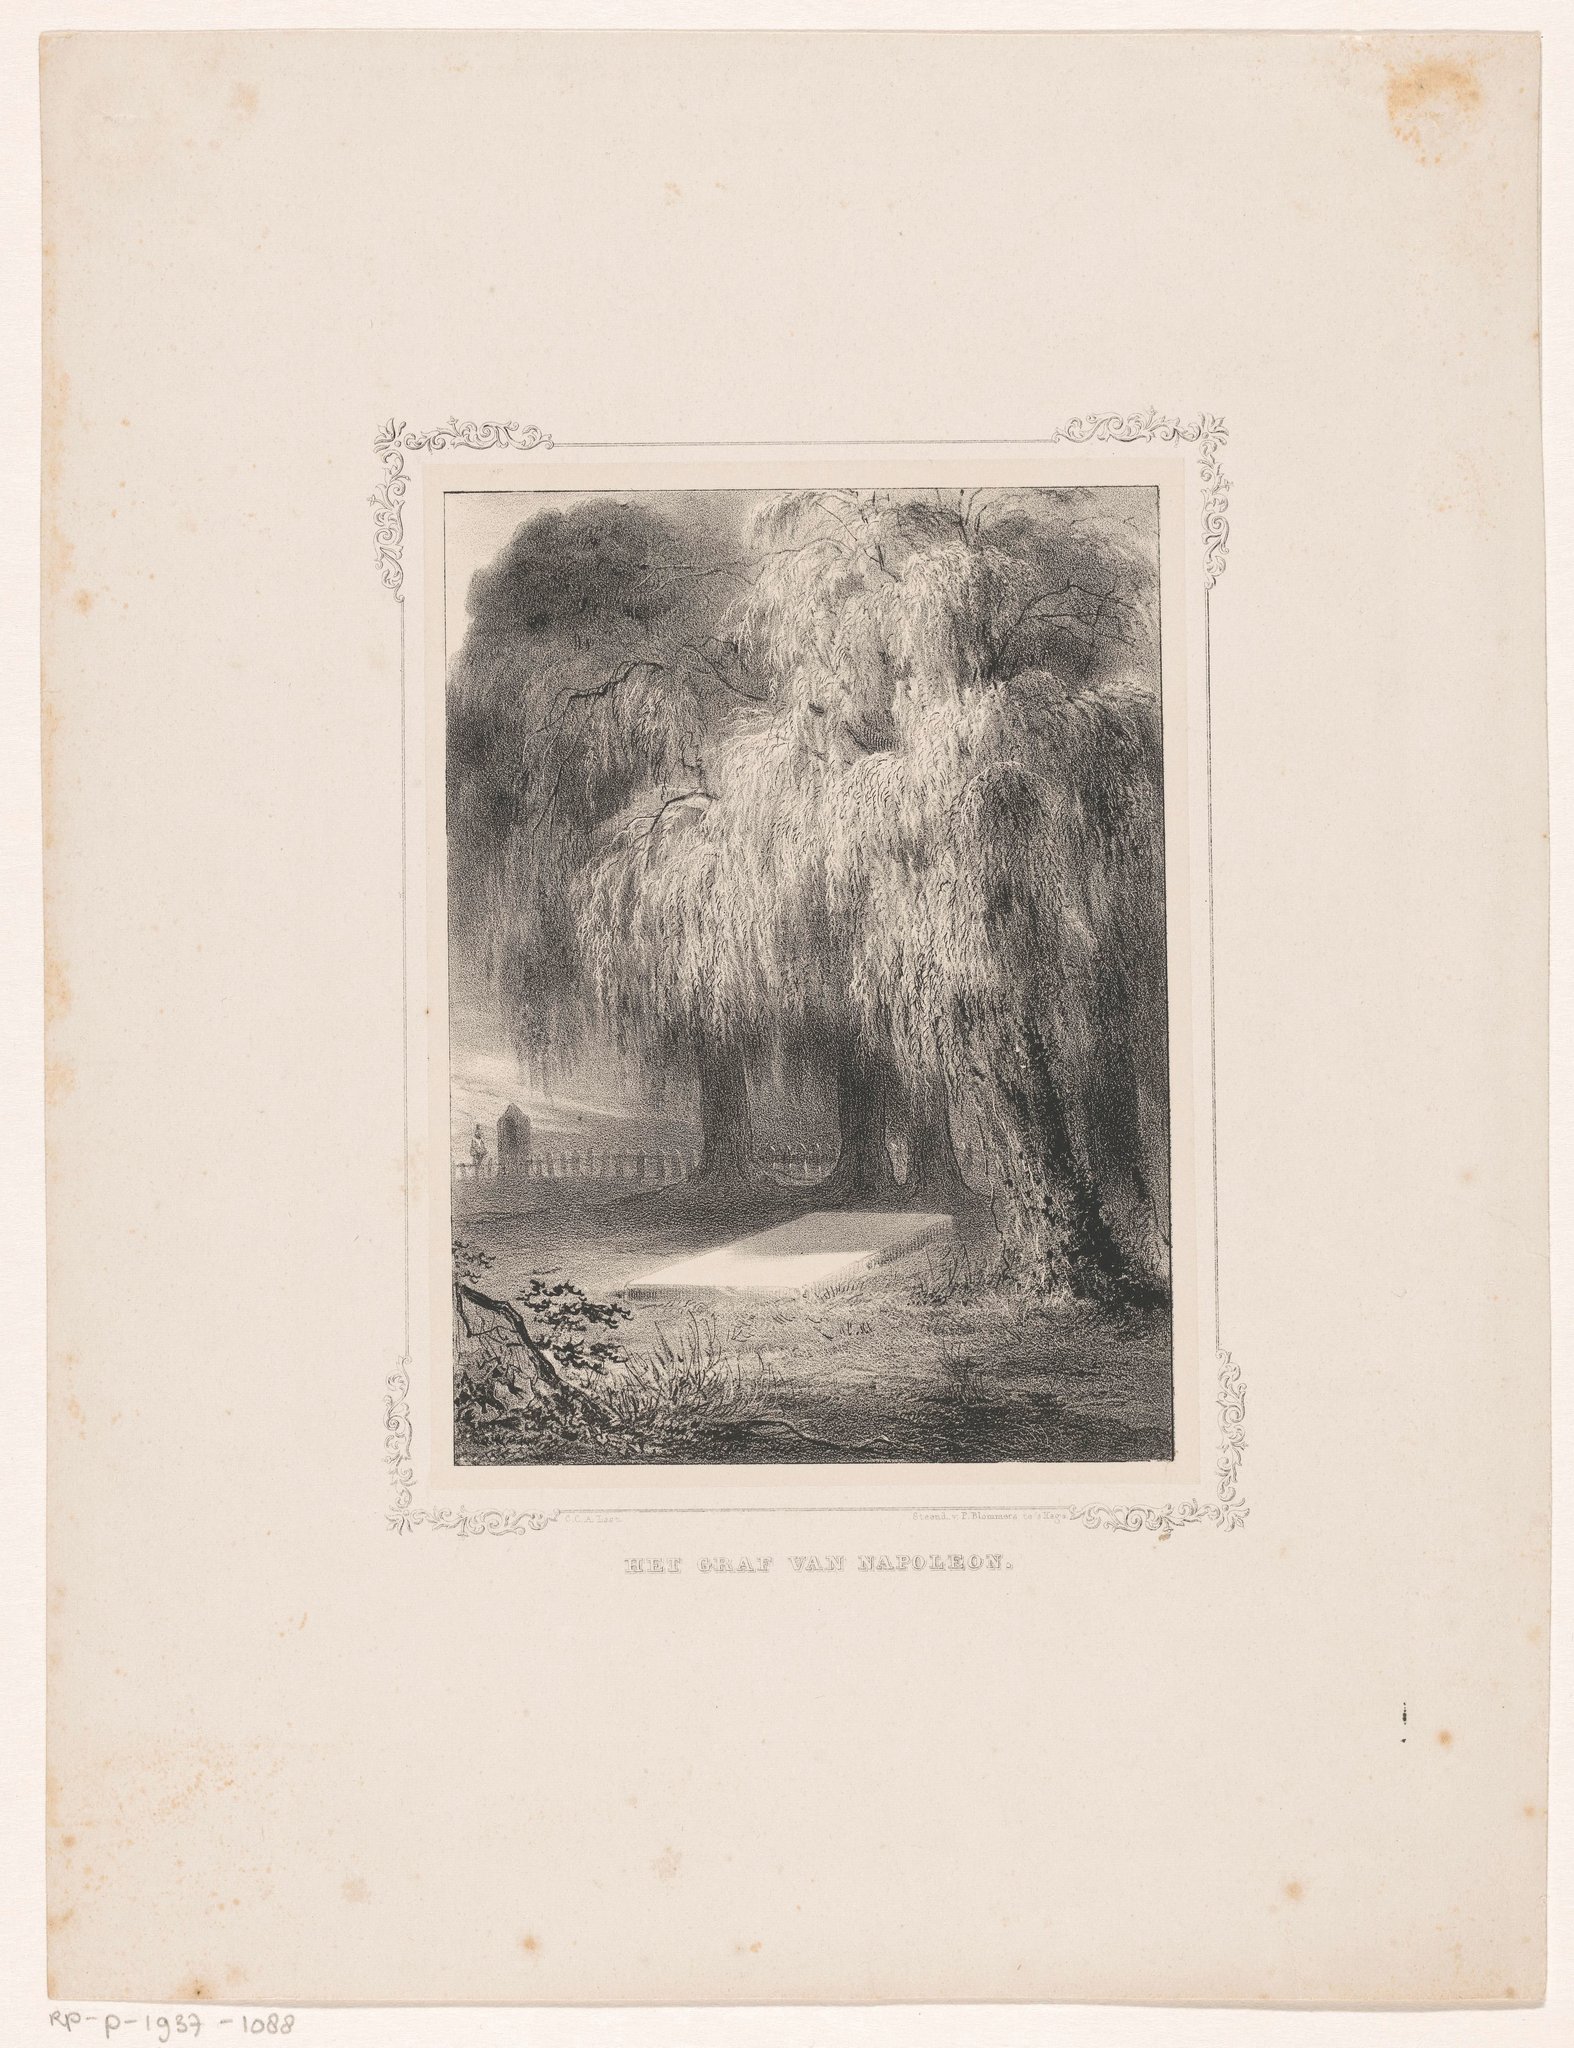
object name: print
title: Het graf van Napoleon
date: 1842-1887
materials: paper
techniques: lithograph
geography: the hague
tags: napoleon i (emperor of the french), gravestone, tombstone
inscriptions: collector's mark: Lugt 2228